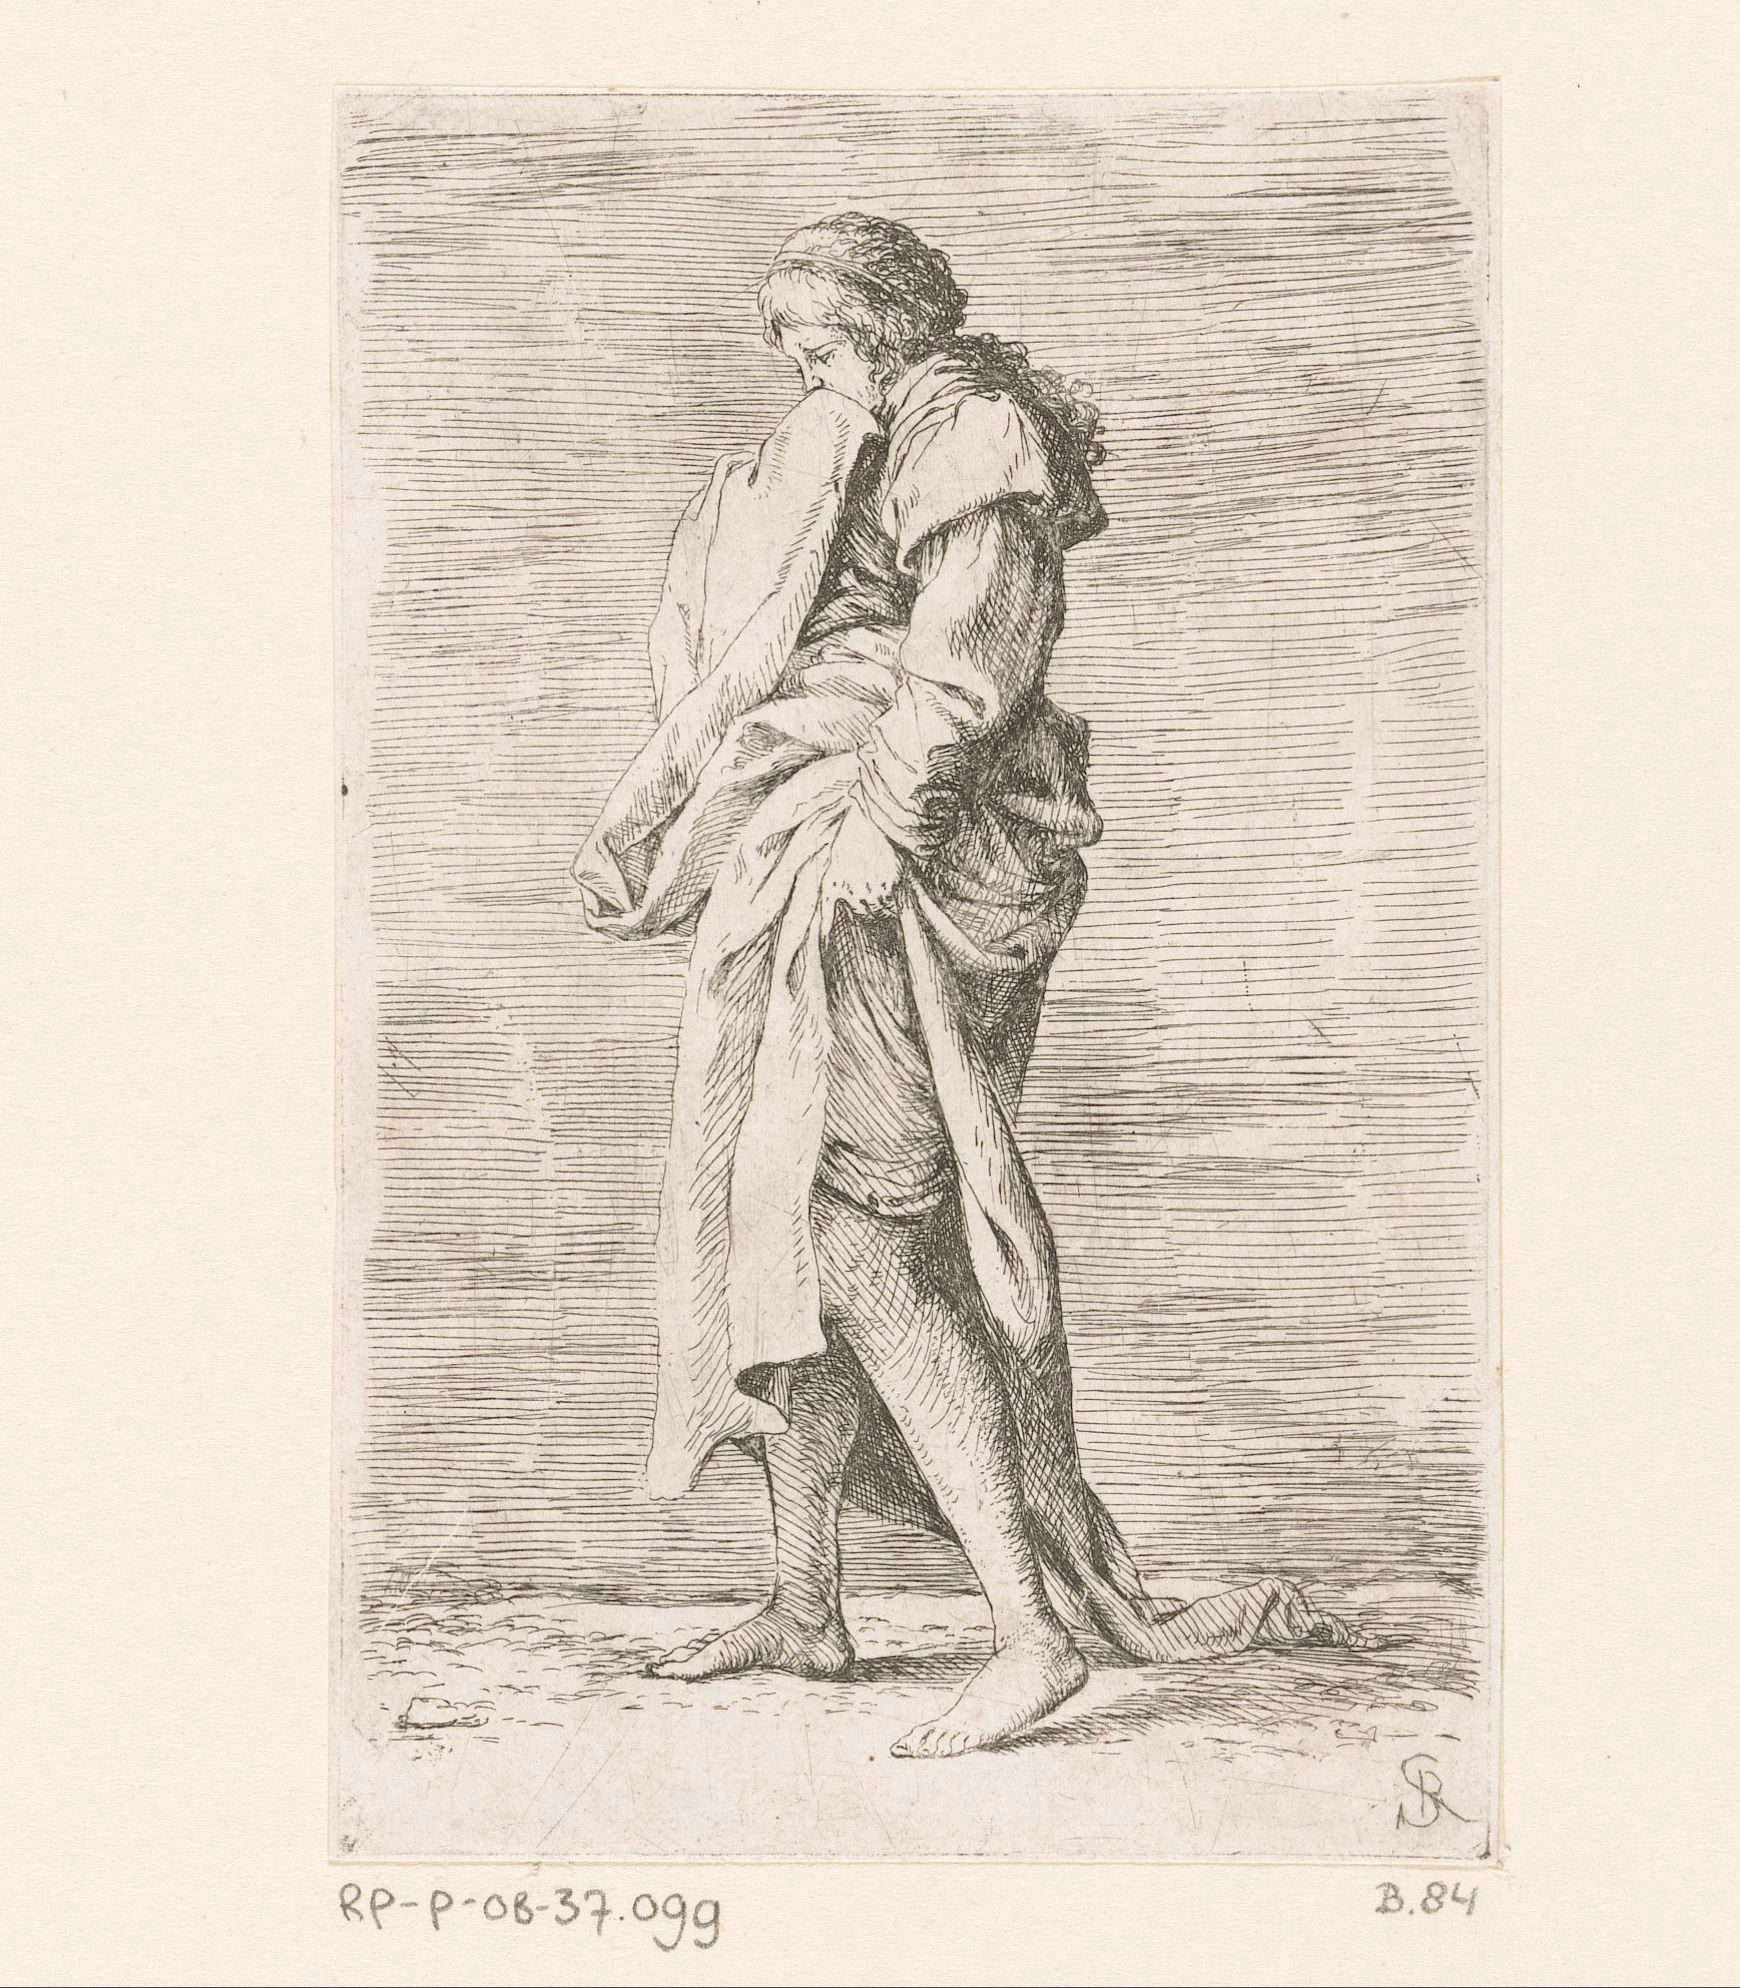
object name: print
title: Figurine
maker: salvator rosa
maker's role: draughtsman, painter, print maker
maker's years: 1615-1673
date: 1656-1657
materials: paper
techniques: drypoint, etching, intaglio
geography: italy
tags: walking - aa - female human figure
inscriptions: collector's mark: Lugt 240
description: Prent spiegelbeeldig naar een andere prent door Rosa, naar een spiegelbeeldige tekening die zich eens bevond in de collectie van Ladislao Odescalchi te Rome. De tekening werd in 1974 geveild te Berlijn. Deze prent maakt deel uit van de serie 'Figurine', bestaande uit een titelprent en 80 prenten van klein formaat met voorstellingen van mannelijke en vrouwelijke figuren. Rosa produceerde de serie waarschijnlijk gedurende de jaren 1656 en 1657.